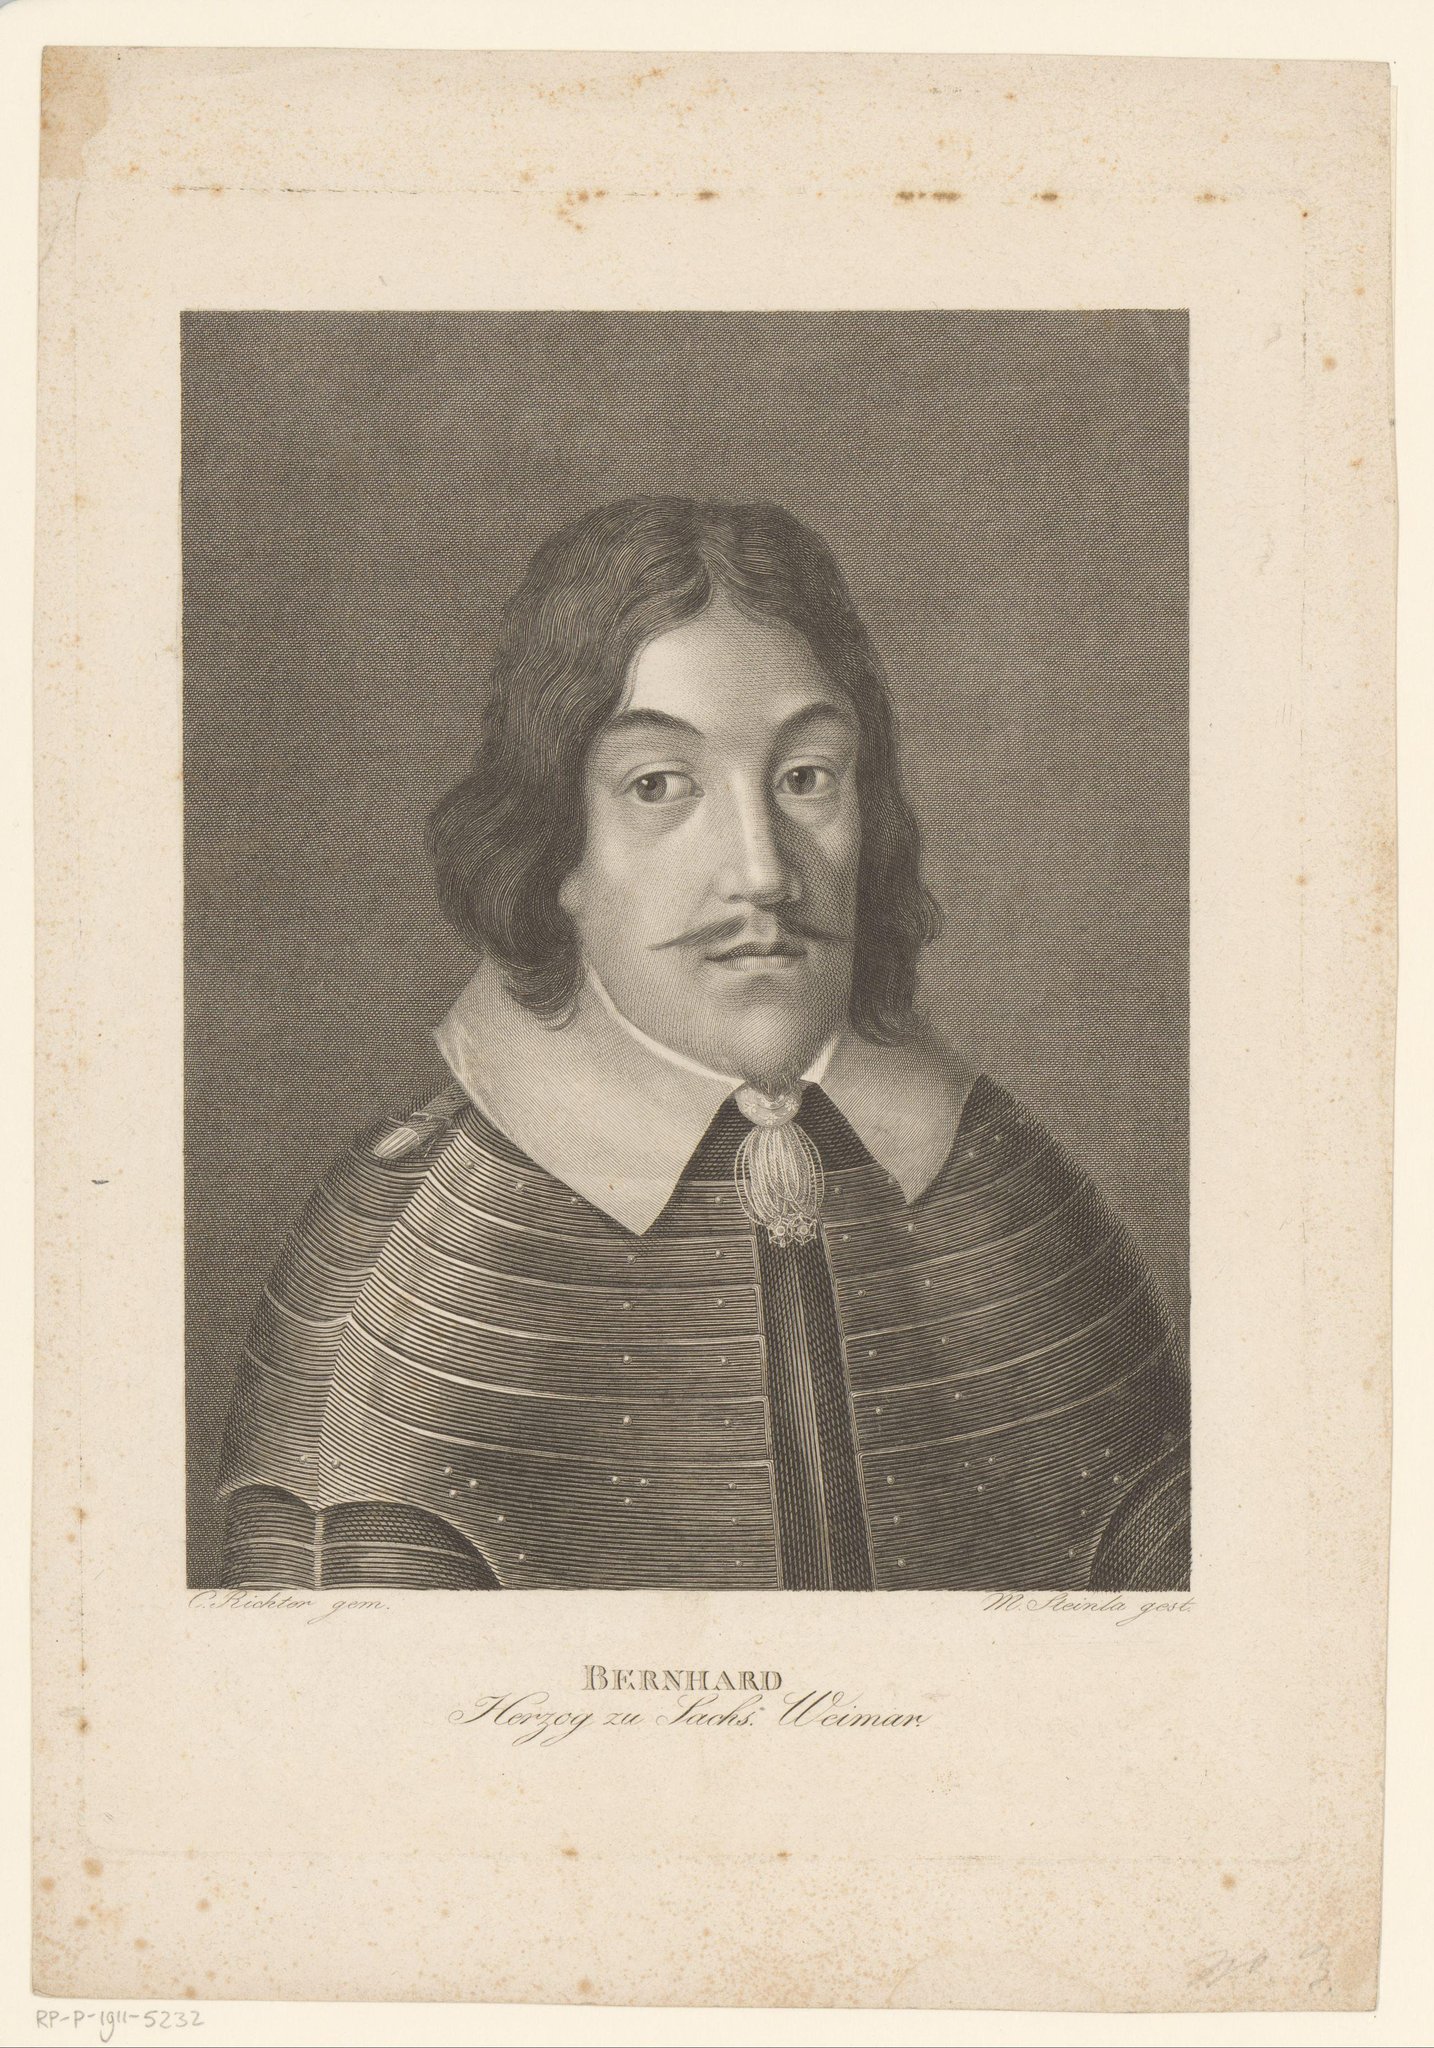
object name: print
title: Portret van Bernhard, hertog van Saksen-Weimar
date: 1801-1858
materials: paper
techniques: engraving, etching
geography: germany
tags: armour, historical persons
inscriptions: collector's mark: Lugt 2228